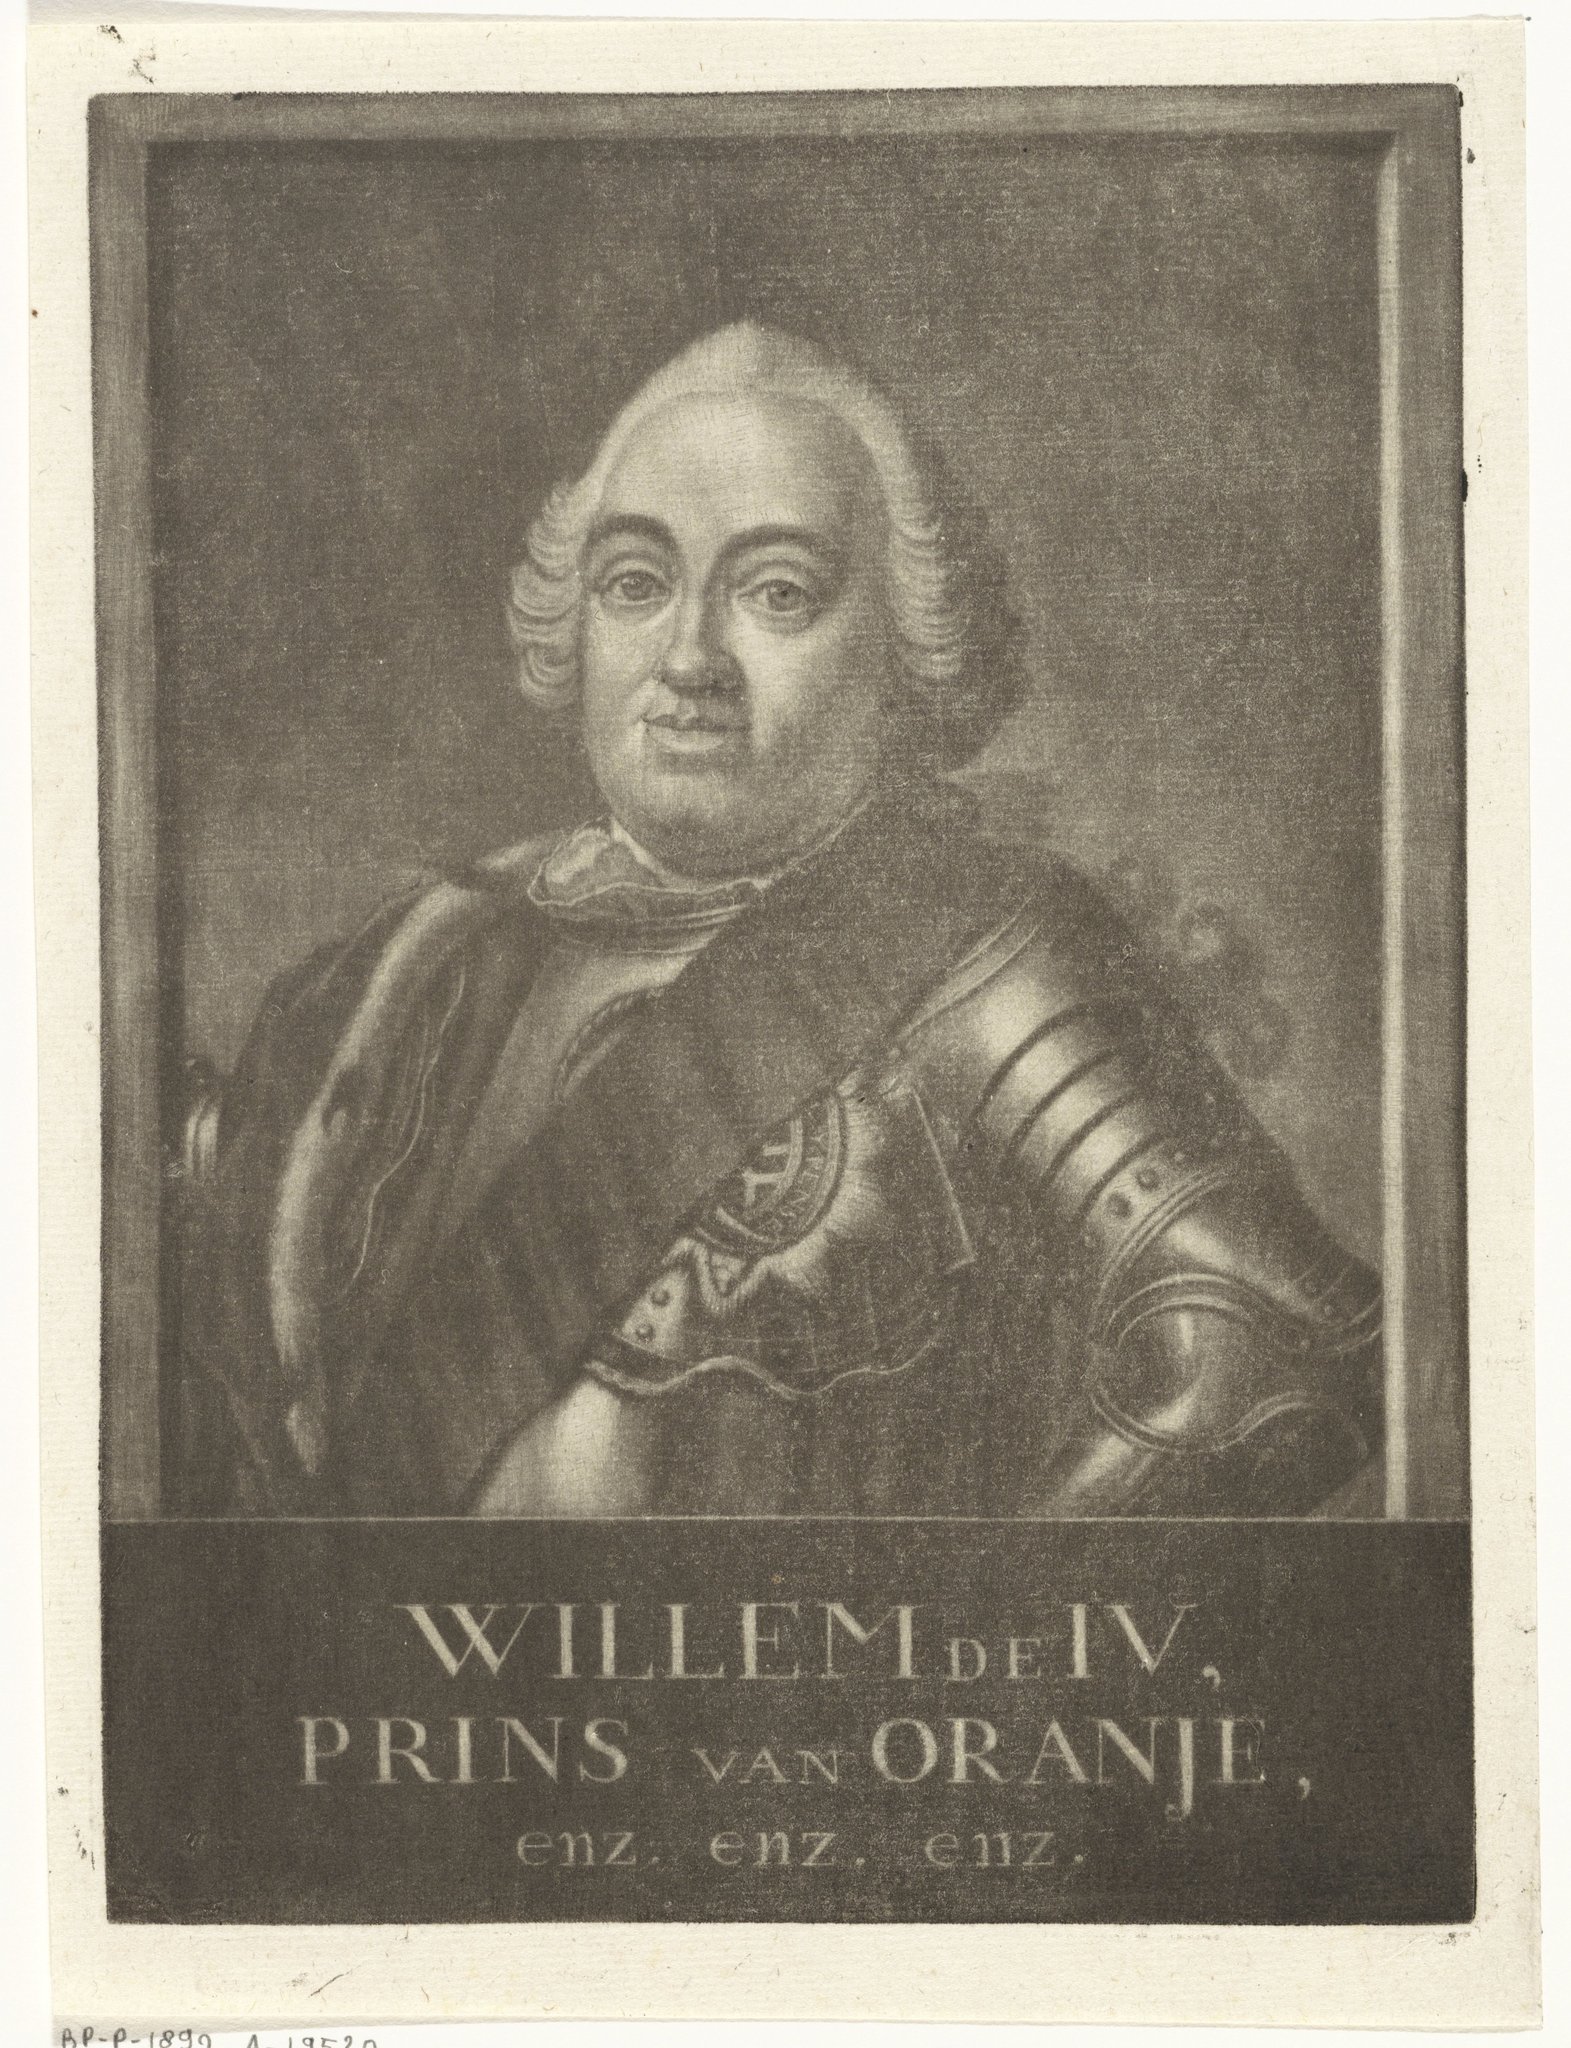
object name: print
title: Portret van Willem IV, prins van Oranje en Nassau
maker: rienk jelgerhuis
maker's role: draughtsman, print maker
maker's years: 1729-1806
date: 1770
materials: paper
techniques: mezzotint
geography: leeuwarden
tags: the hague, willem iv (prins van oranje-nassau), harness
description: Ook gebruikt als illustratie in: Bosch, Johannes van den. De heeren stadhouderen van Vriesland, zedert den jare acht-hondert. Leeuwarden: Abraham Ferwerda en G.Tresling, 1770.